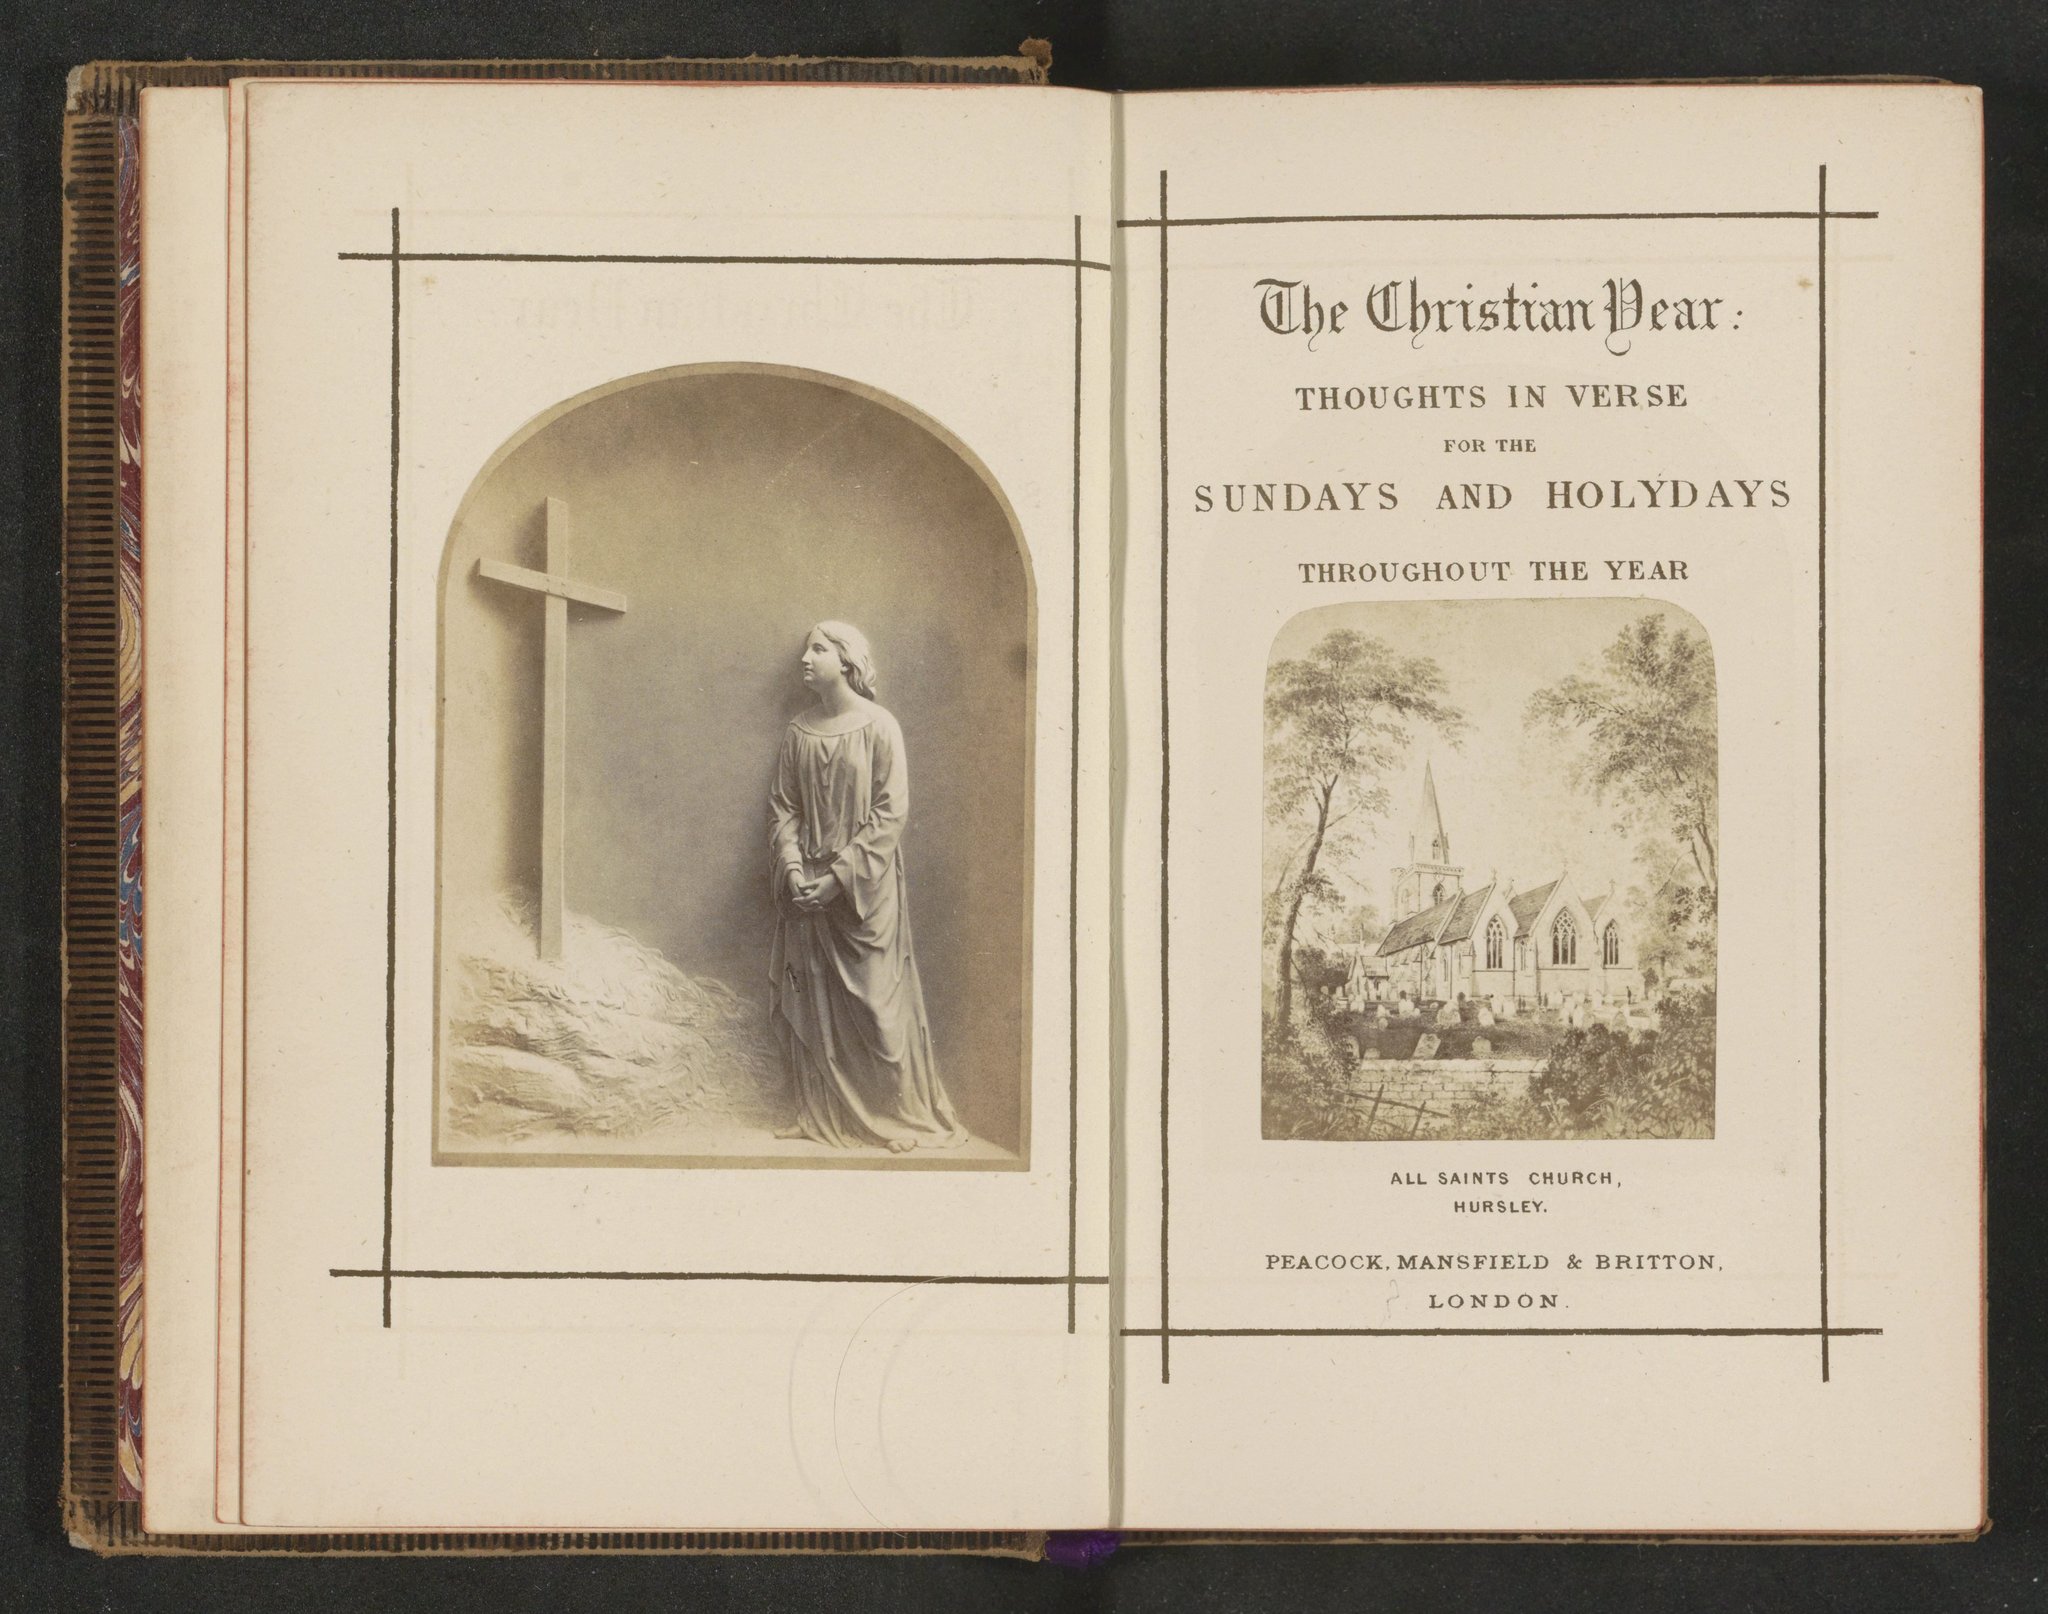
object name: reproduction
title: Fotoreproductie van een schilderij, voorstellende een vrouw voor een kruis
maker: Anonymous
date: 1865-1870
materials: photographic support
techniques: albumen print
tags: adult woman, the cross ~ symbols of christ